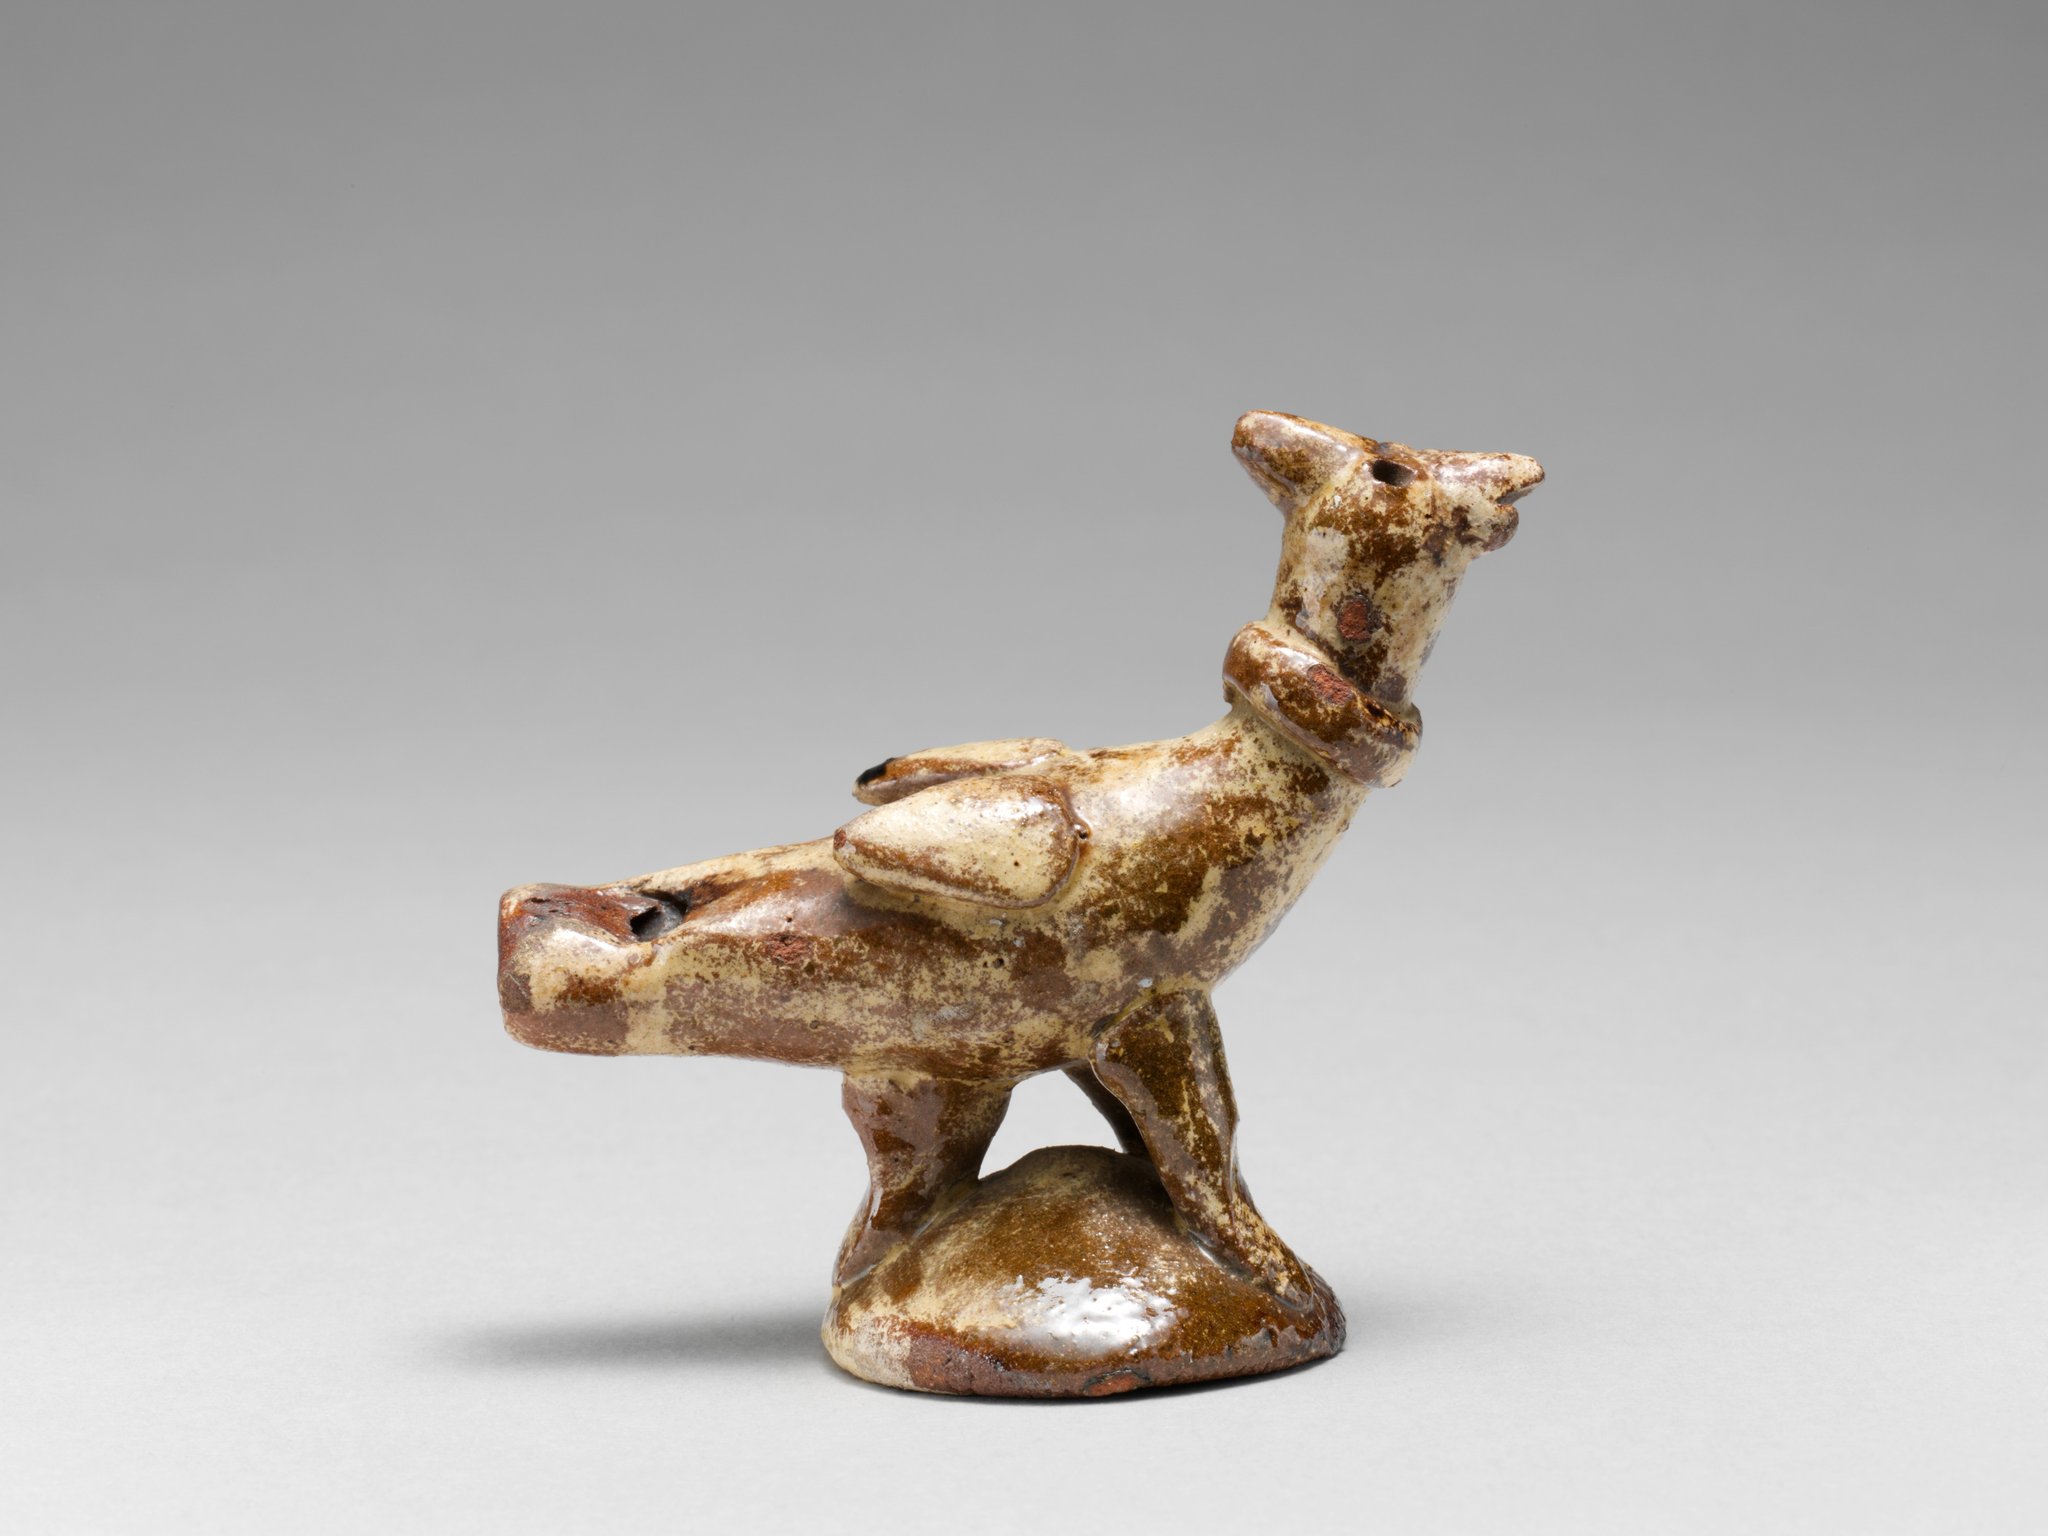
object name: pottery whistle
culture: peruvian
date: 1801-1900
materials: clay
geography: peru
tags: birds